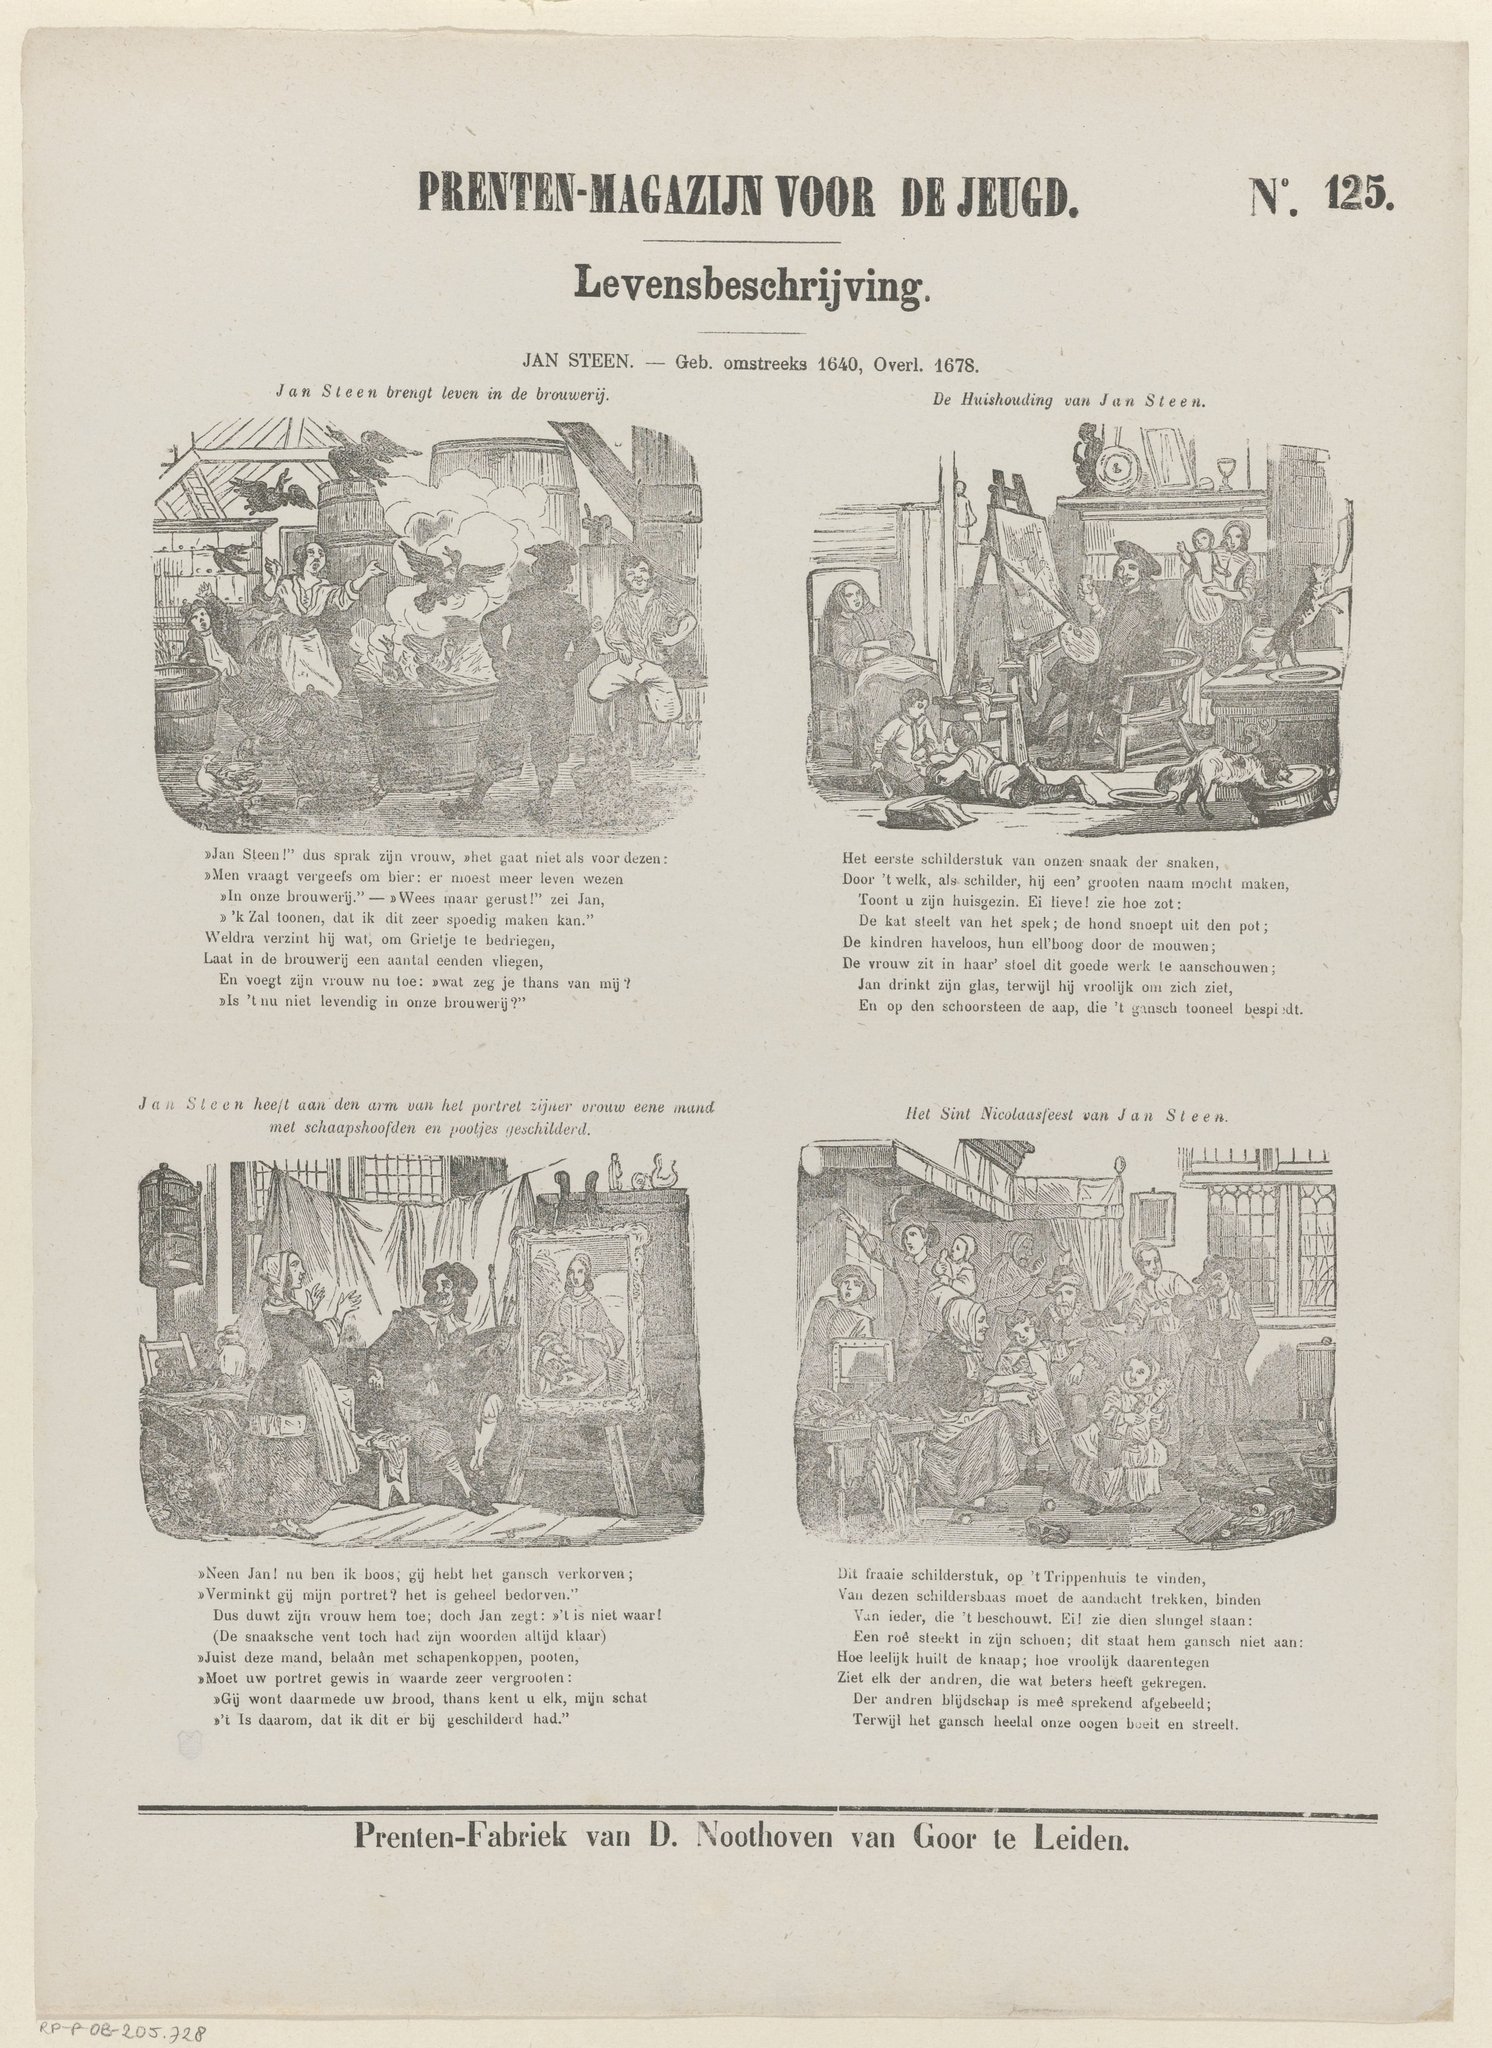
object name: print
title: Levensbeschrijving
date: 1850-1881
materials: paper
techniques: letterpress printing, engraving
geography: leiden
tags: leiden, painter, print maker, jan havicksz. steen, a perfect shambles (dutch: 'huishouden van jan steen'), historical persons, workshop, studio ~ painter, painter at work, in his studio, festivities on st. nicholas (eve) (december 5), picture, painting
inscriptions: collector's mark: Lugt 2760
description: Blad met 4 voorstellingen uit het leven van Jan Havicksz. Steen. Boven elke afbeelding een titel, onder elke afbeelding een achtregelig vers. Genummerd rechtsboven: No. 125.